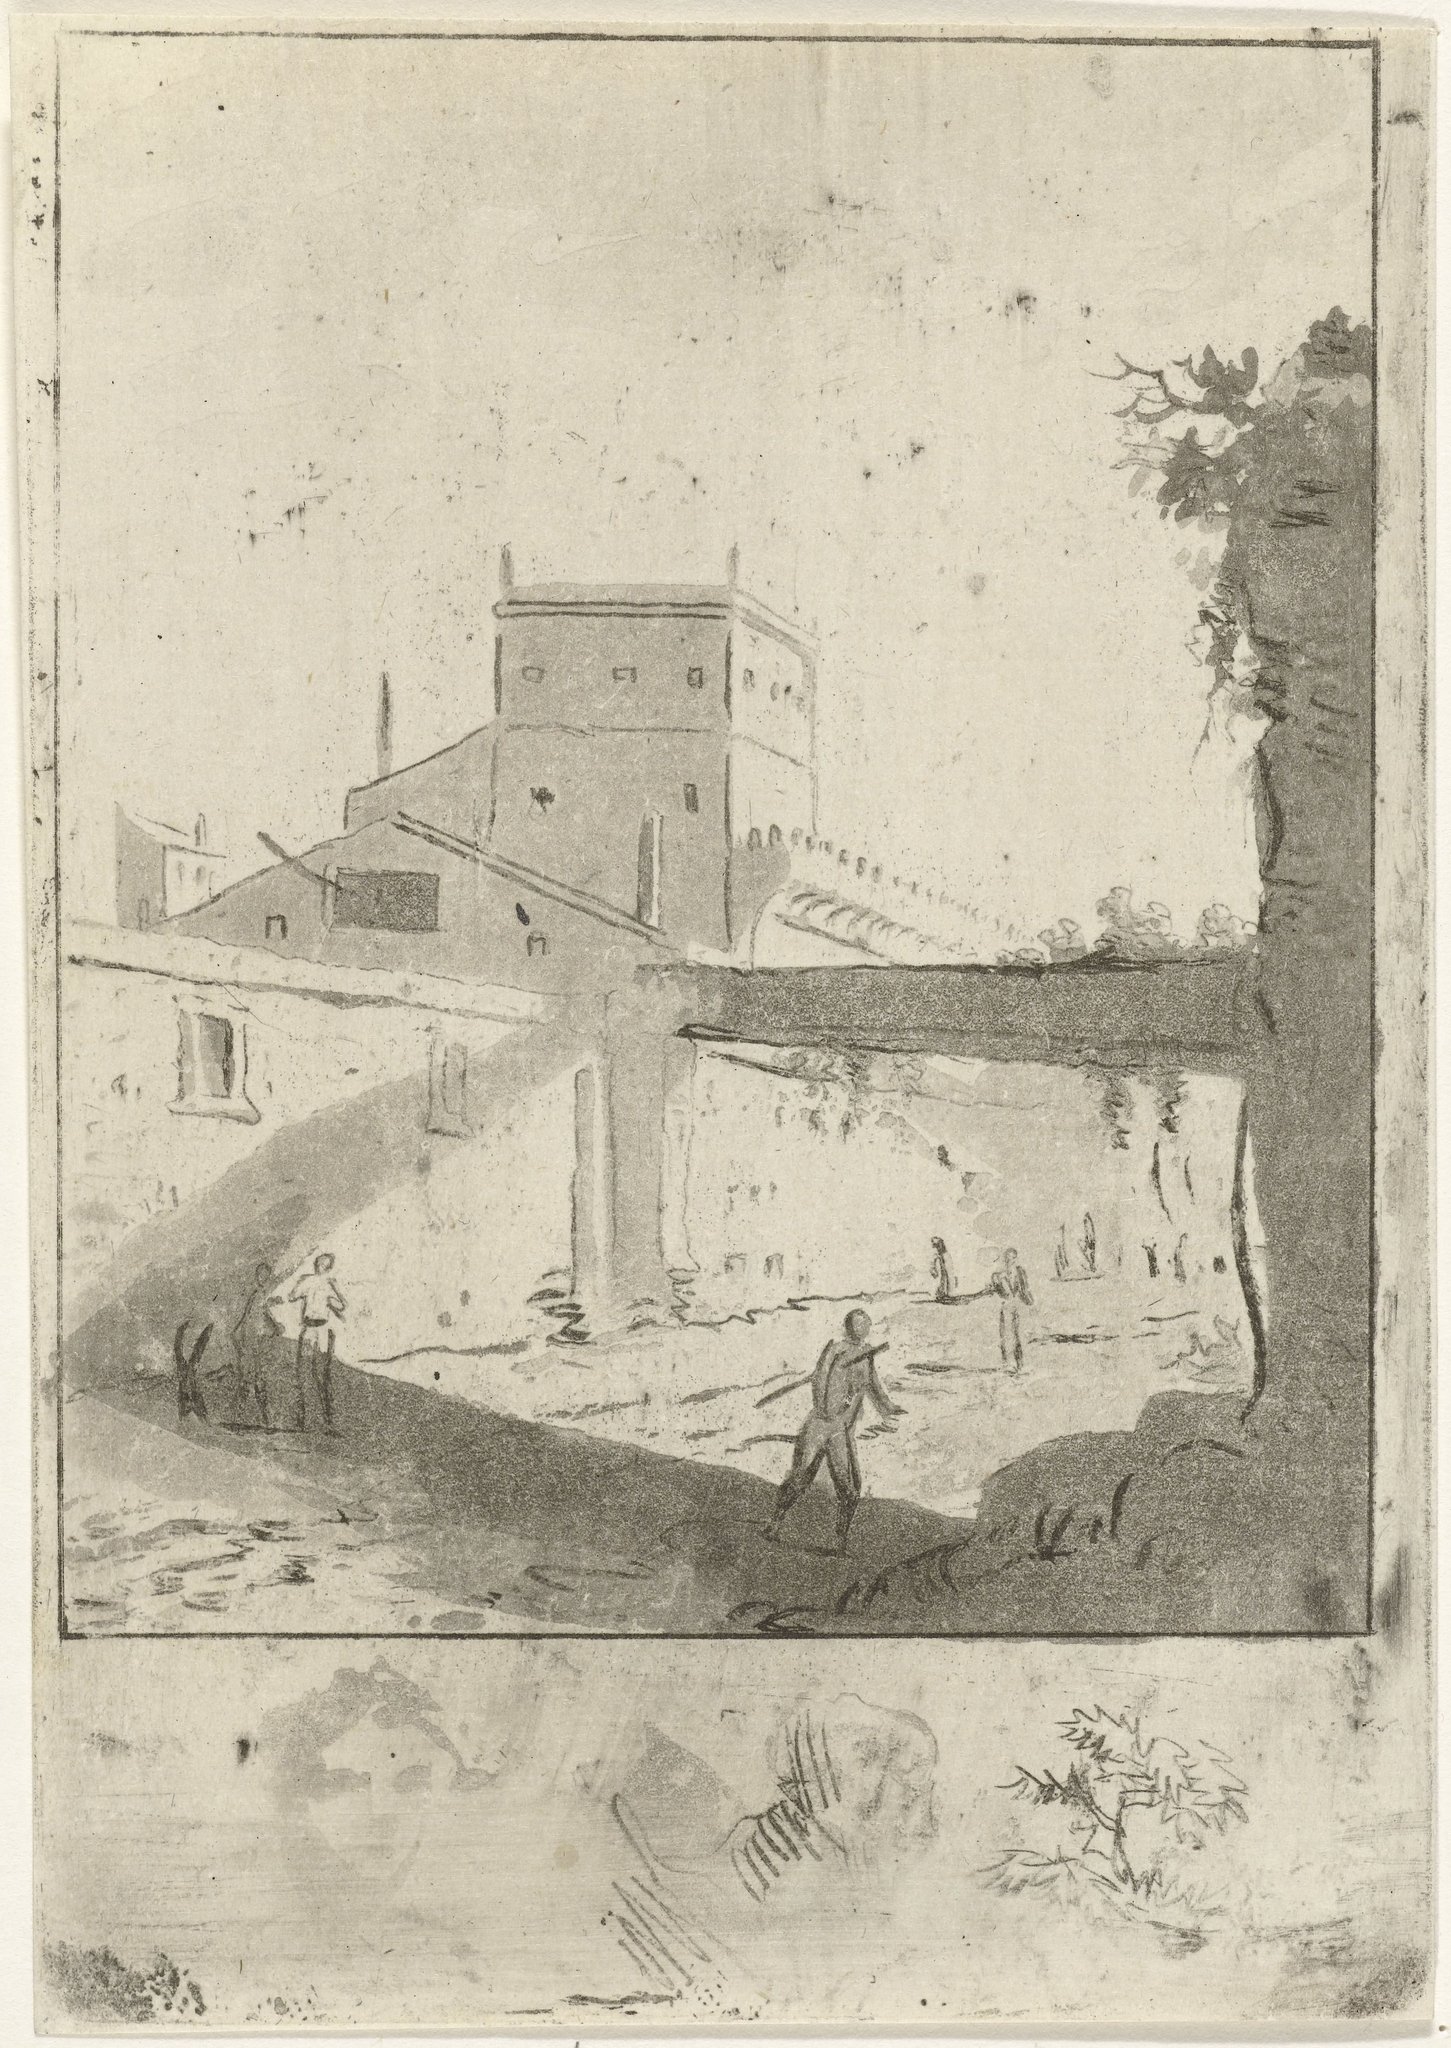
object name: print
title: Italiaans landschap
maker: hermanus fock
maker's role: conservator, draughtsman, painter, print maker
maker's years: 1766-1822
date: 1781-1822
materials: paper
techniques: aquatint, etching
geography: amsterdam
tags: city-view in general; 'veduta' - ii - ideal city (+ city(-scape) with figures, staffage)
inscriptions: collector's mark: Lugt 2228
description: Een gezicht op een straat langs een muur en bebouwing. Een balk werpt een schaduw op de straat waar verschillende mensen lopen. Onder de voorstelling enkele oefeningen, waaronder een gezicht en een bladmotief, in verschillende technieken.